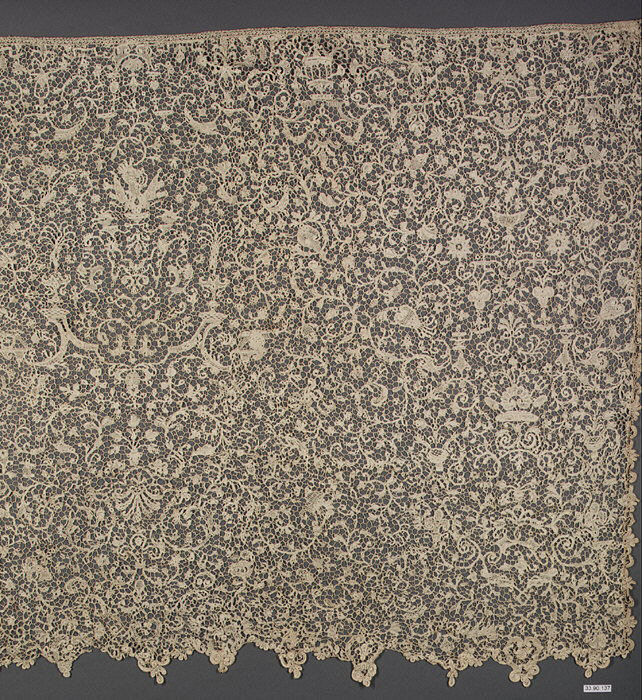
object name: flounce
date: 1700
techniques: lace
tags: flowers